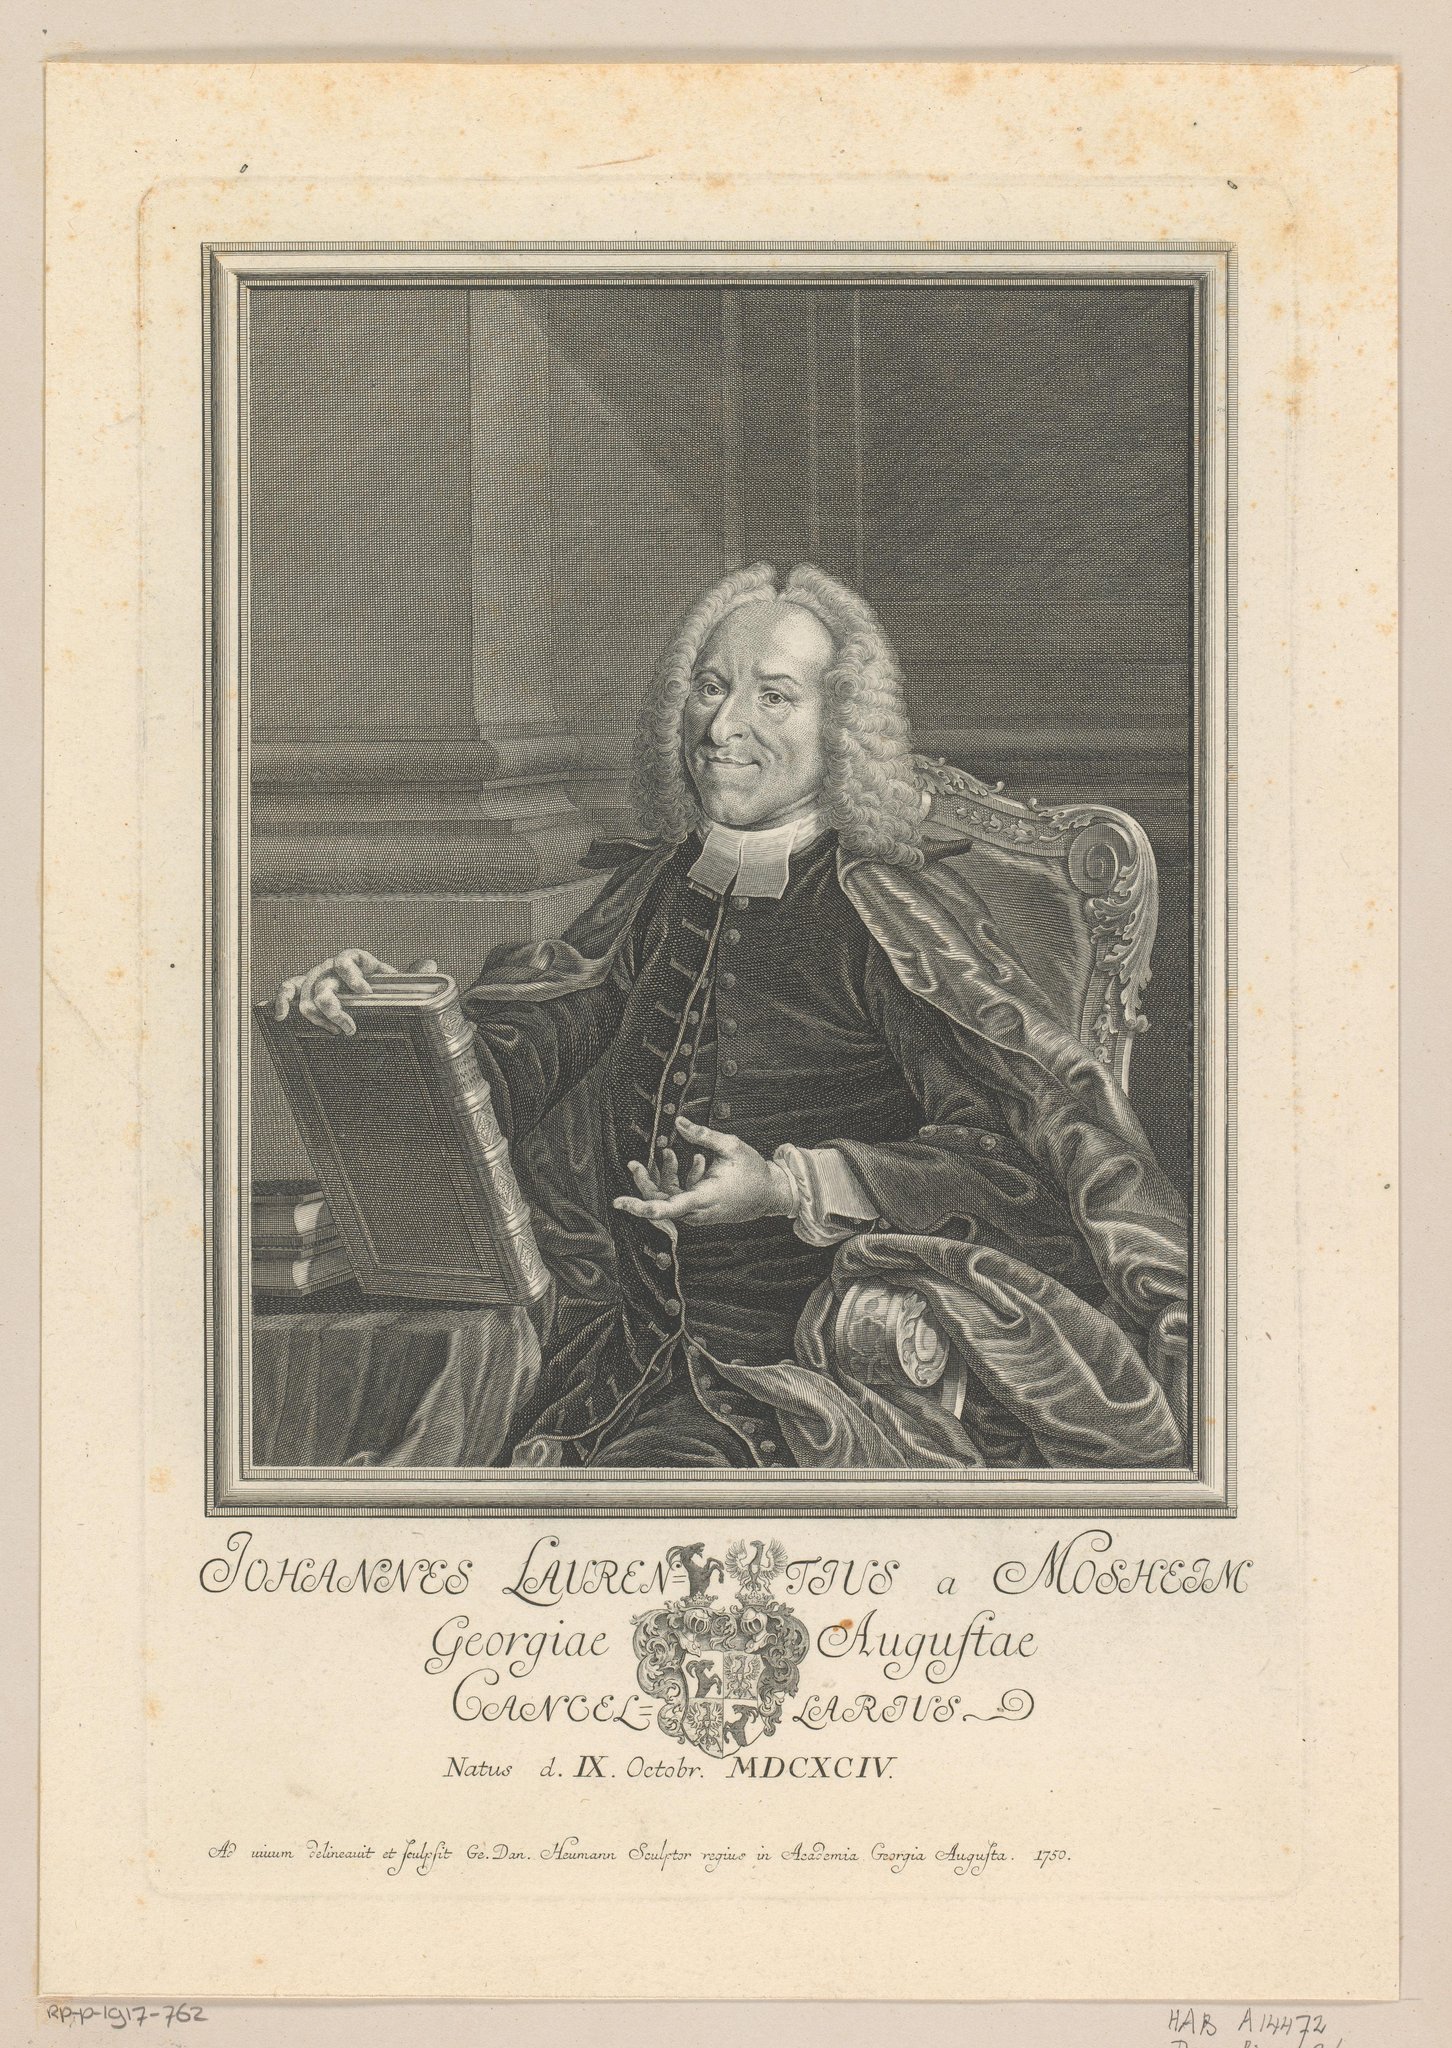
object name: print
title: Johannes Lauren=tius a Moscheim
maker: georg daniel heumann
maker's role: print maker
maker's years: 1691-1759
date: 1750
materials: paper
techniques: engraving, etching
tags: historical persons, armorial bearing, heraldry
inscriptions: collector's mark: Lugt 2228